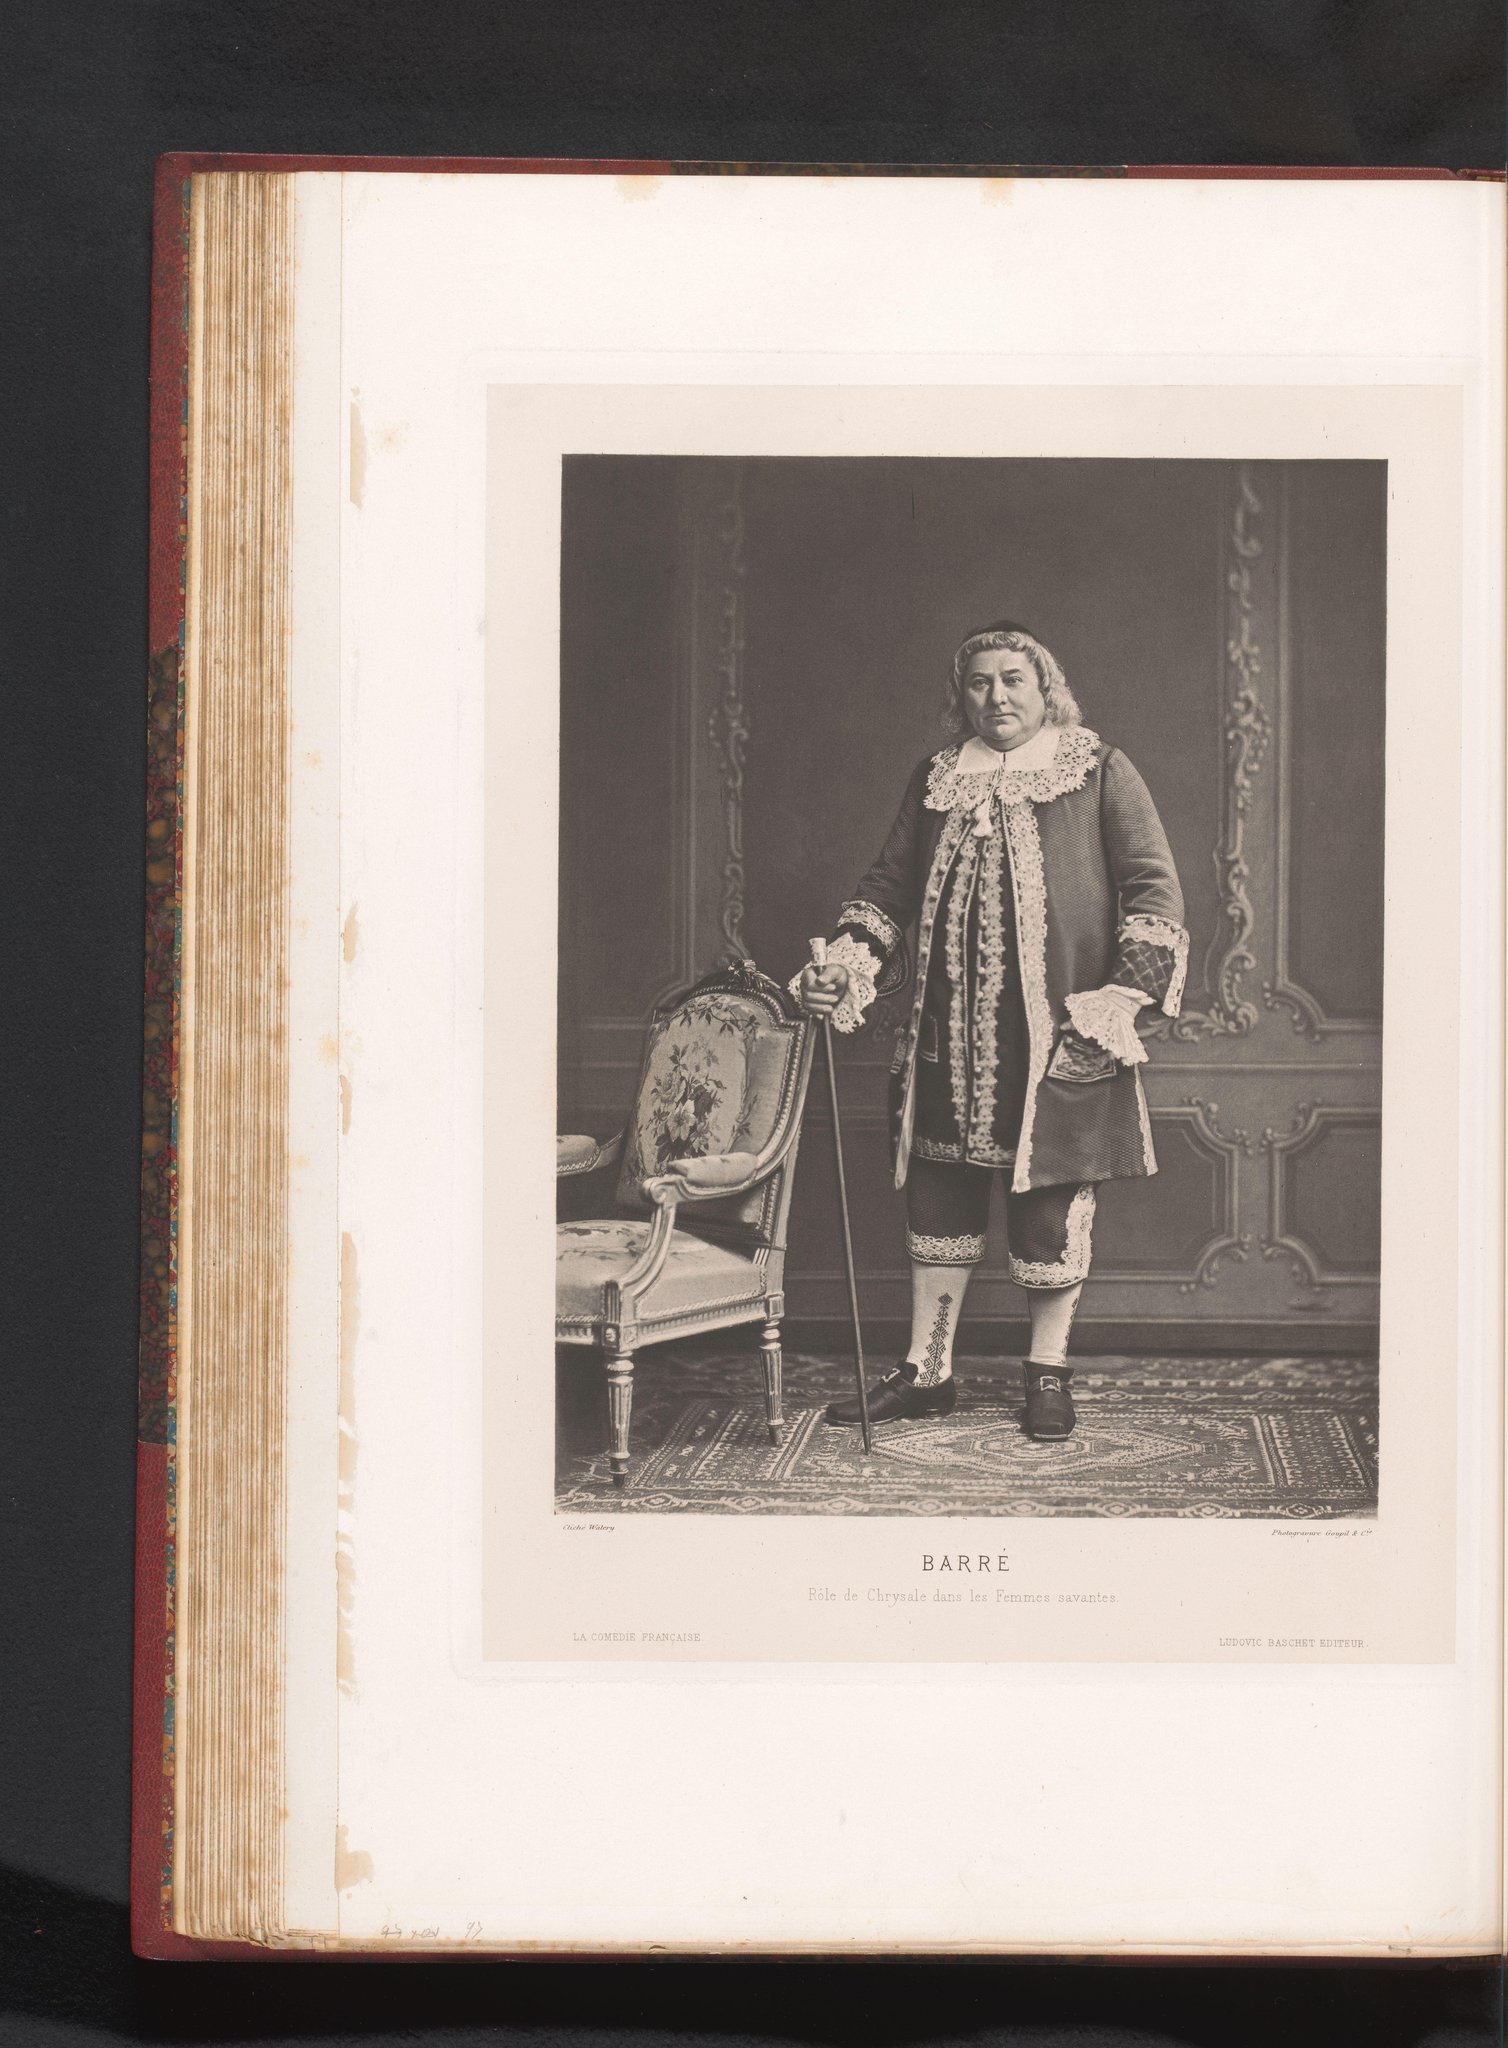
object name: photomechanical print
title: Barré. Rôle de Chrysale dans les Femmes savantes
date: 1875-1880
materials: paper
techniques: photoaquatint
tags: historical persons, portrait of actor, actress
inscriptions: number: ‘97’, inscription: ‘LA COMÉDIE FRANÇAISE’